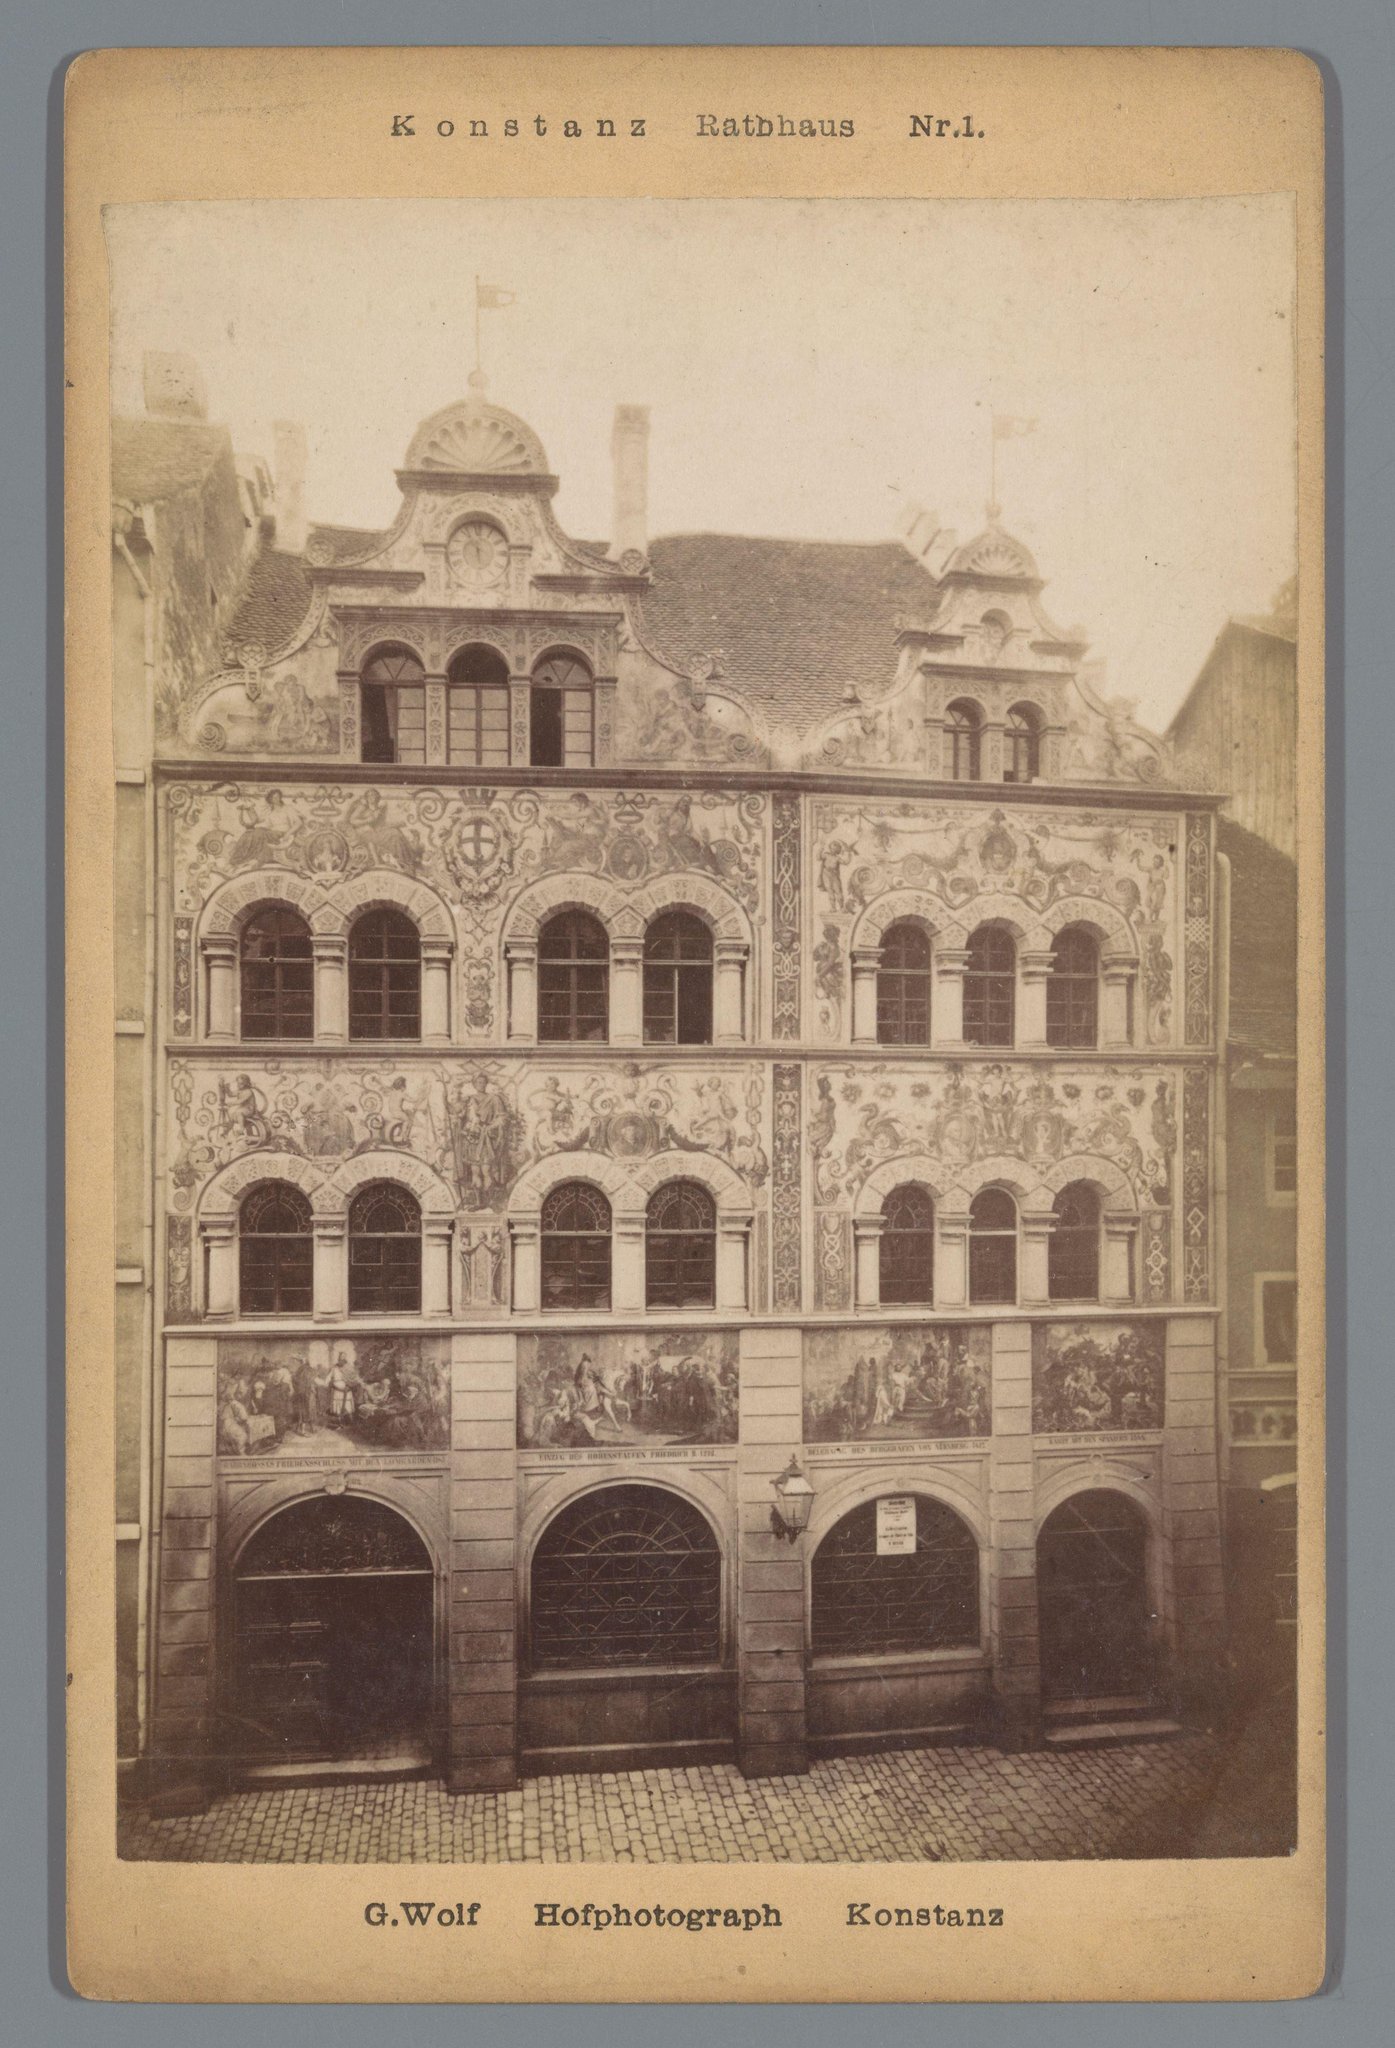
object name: cabinet photograph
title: Gezicht op het stadhuis van Konstanz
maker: german wolf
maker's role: fotograaf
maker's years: 1830-1890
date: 1870-1871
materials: cardboard, photographic support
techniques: albumen print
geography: konstanz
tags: townhall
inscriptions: number: ‘Nr.1.’